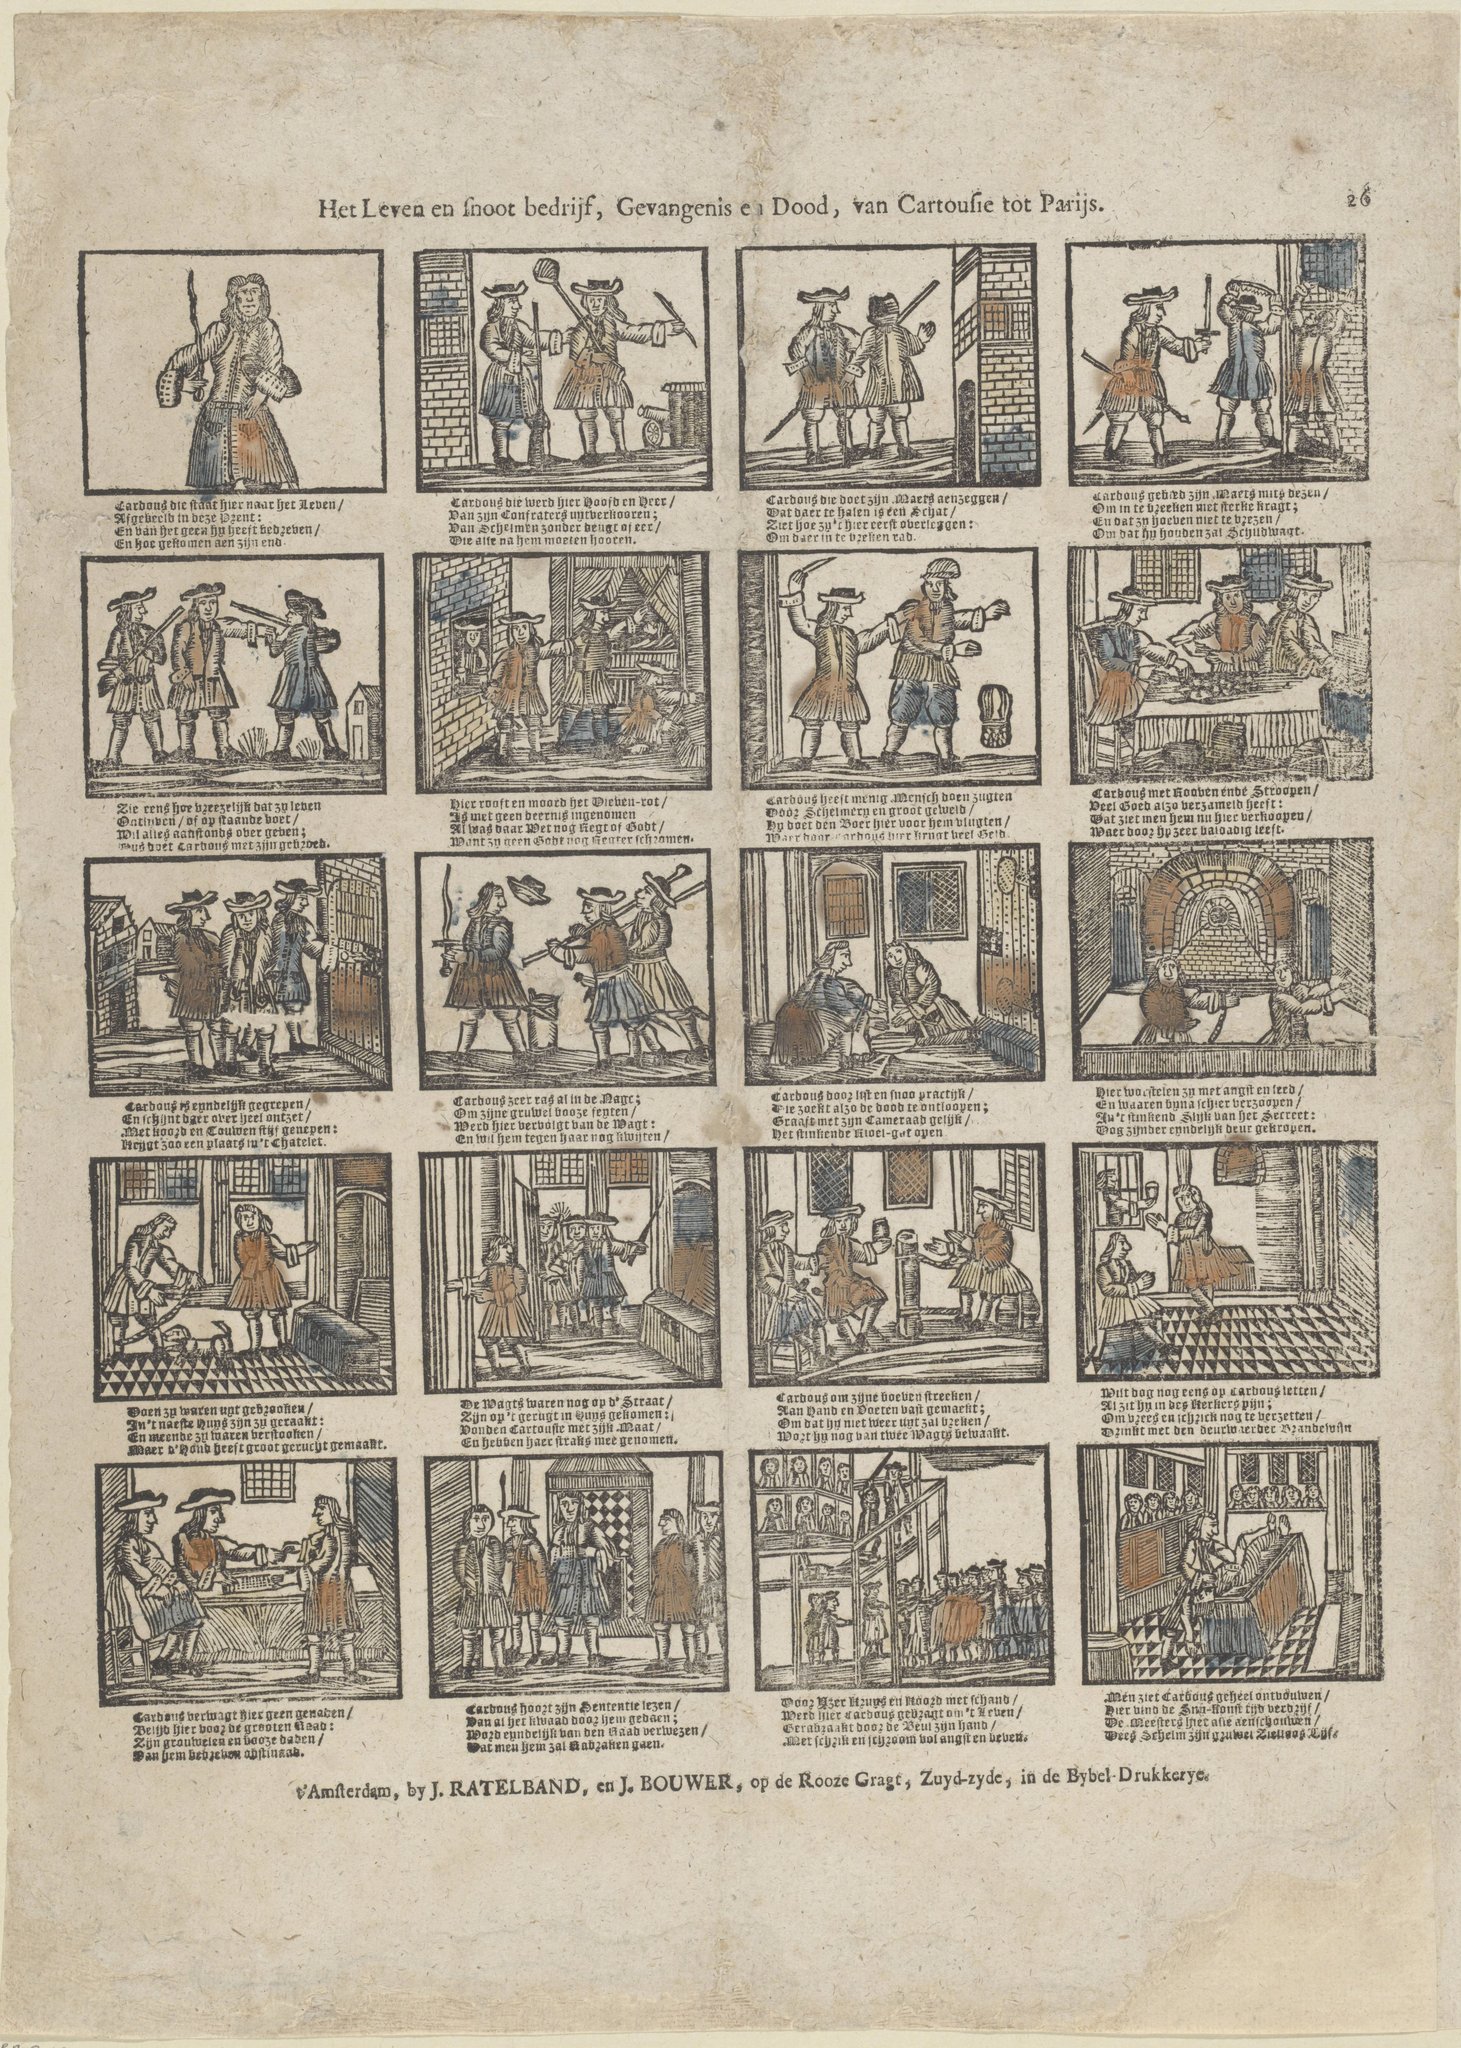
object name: popular print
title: Het leven en snoot bedrijf, gevangenis en dood, van Cartousie tot Parijs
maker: Anonymous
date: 1760-1767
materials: paper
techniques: colour, letterpress printing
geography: netherlands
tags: violent death by hanging, bad behaviour, tales and fairy tales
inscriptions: collector's mark: Lugt 2760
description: Blad met 20 voorstellingen over het leven en de avonturen Cartouche. Onder elke voorstelling een vierregelig vers. Genummerd rechtsboven: 26.